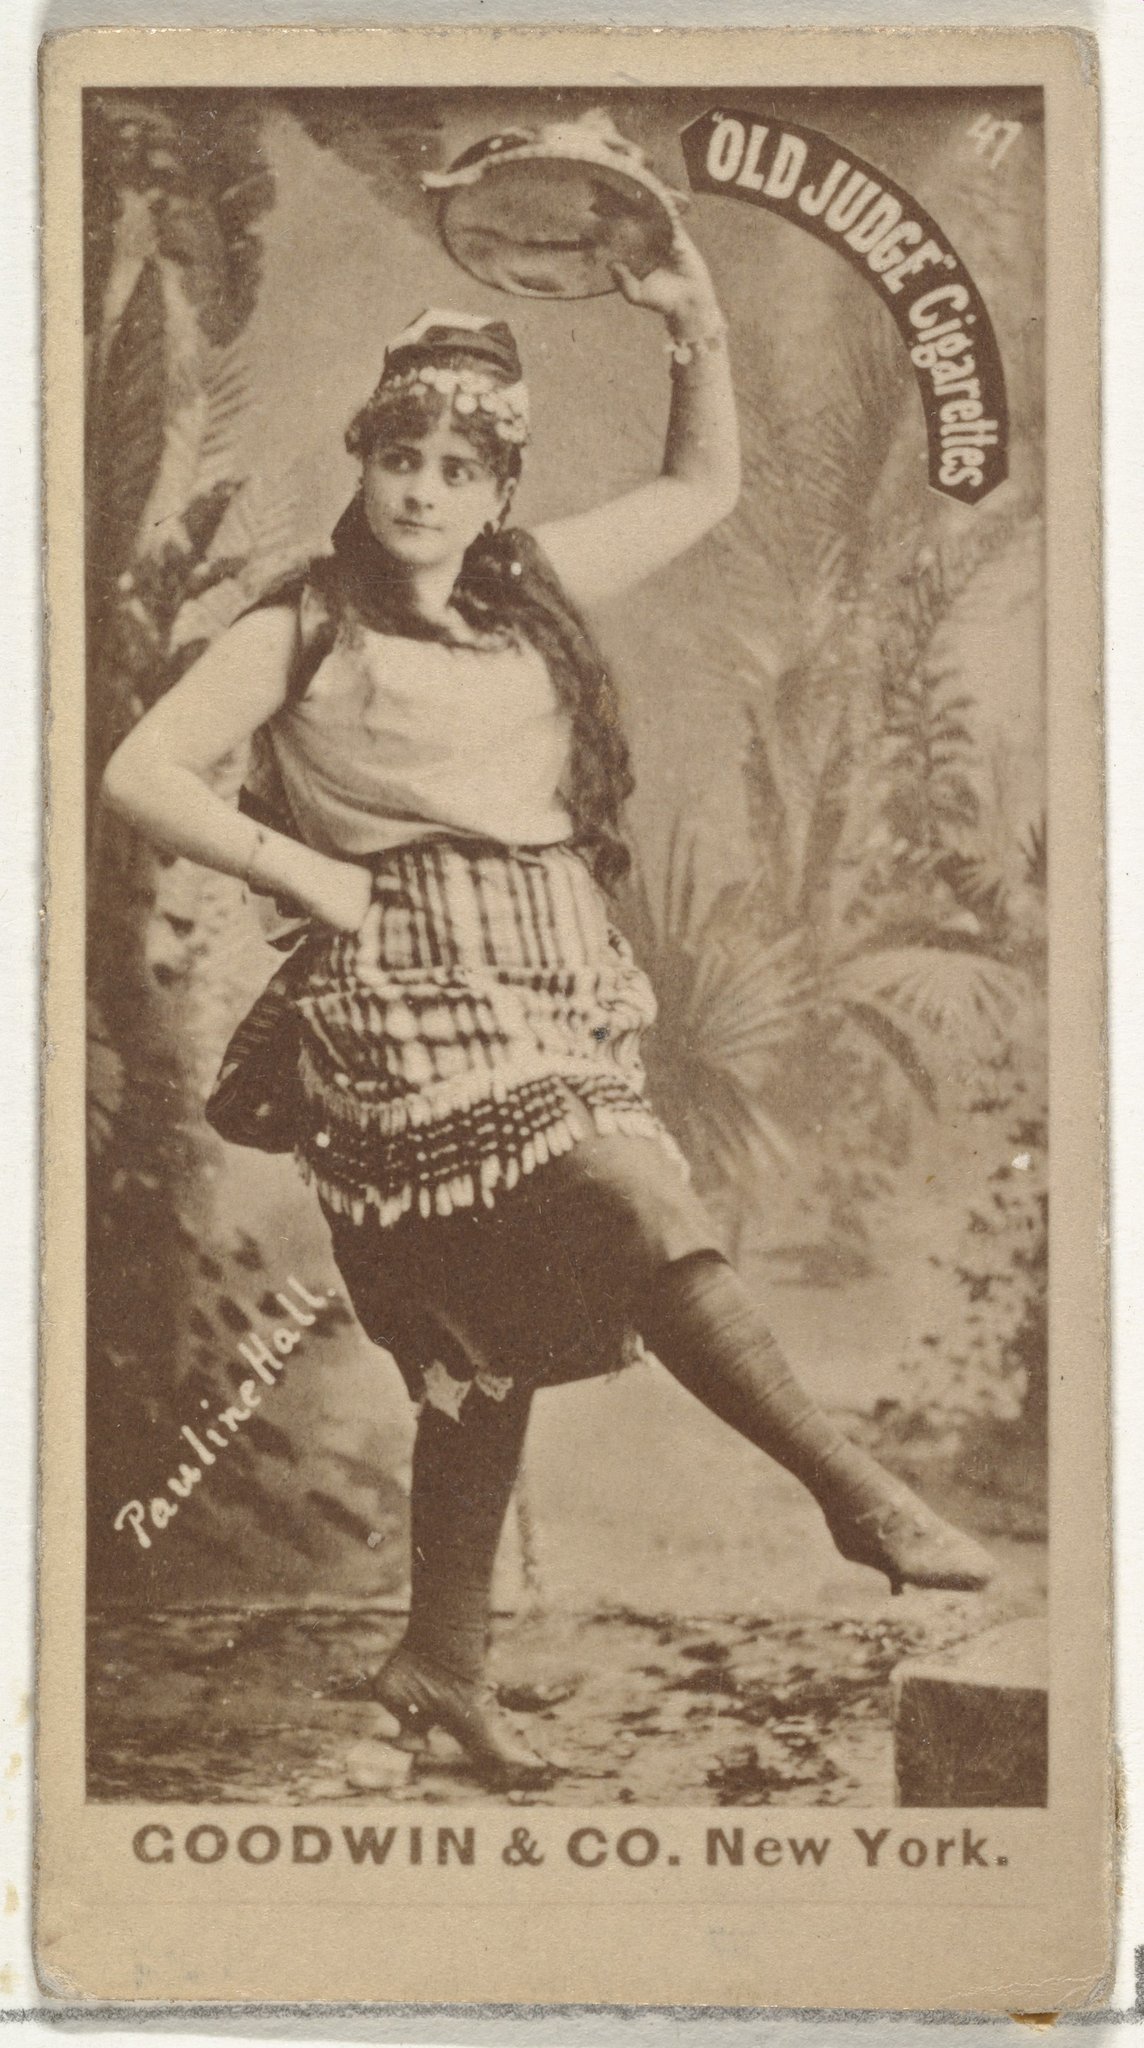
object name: photograph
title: Pauline Hall, from the Actors and Actresses series (N171) for Old Judge Cigarettes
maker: goodwin & company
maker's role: publisher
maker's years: 1850-1950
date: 1886-1890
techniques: albumen silver print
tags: portraits,women,actresses